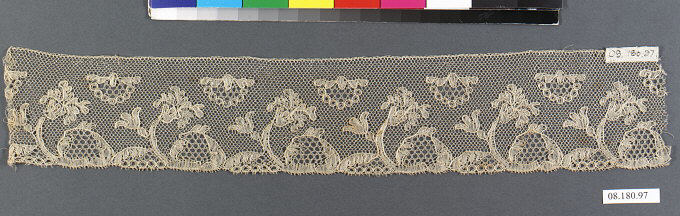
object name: fragment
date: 1801-1900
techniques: lace